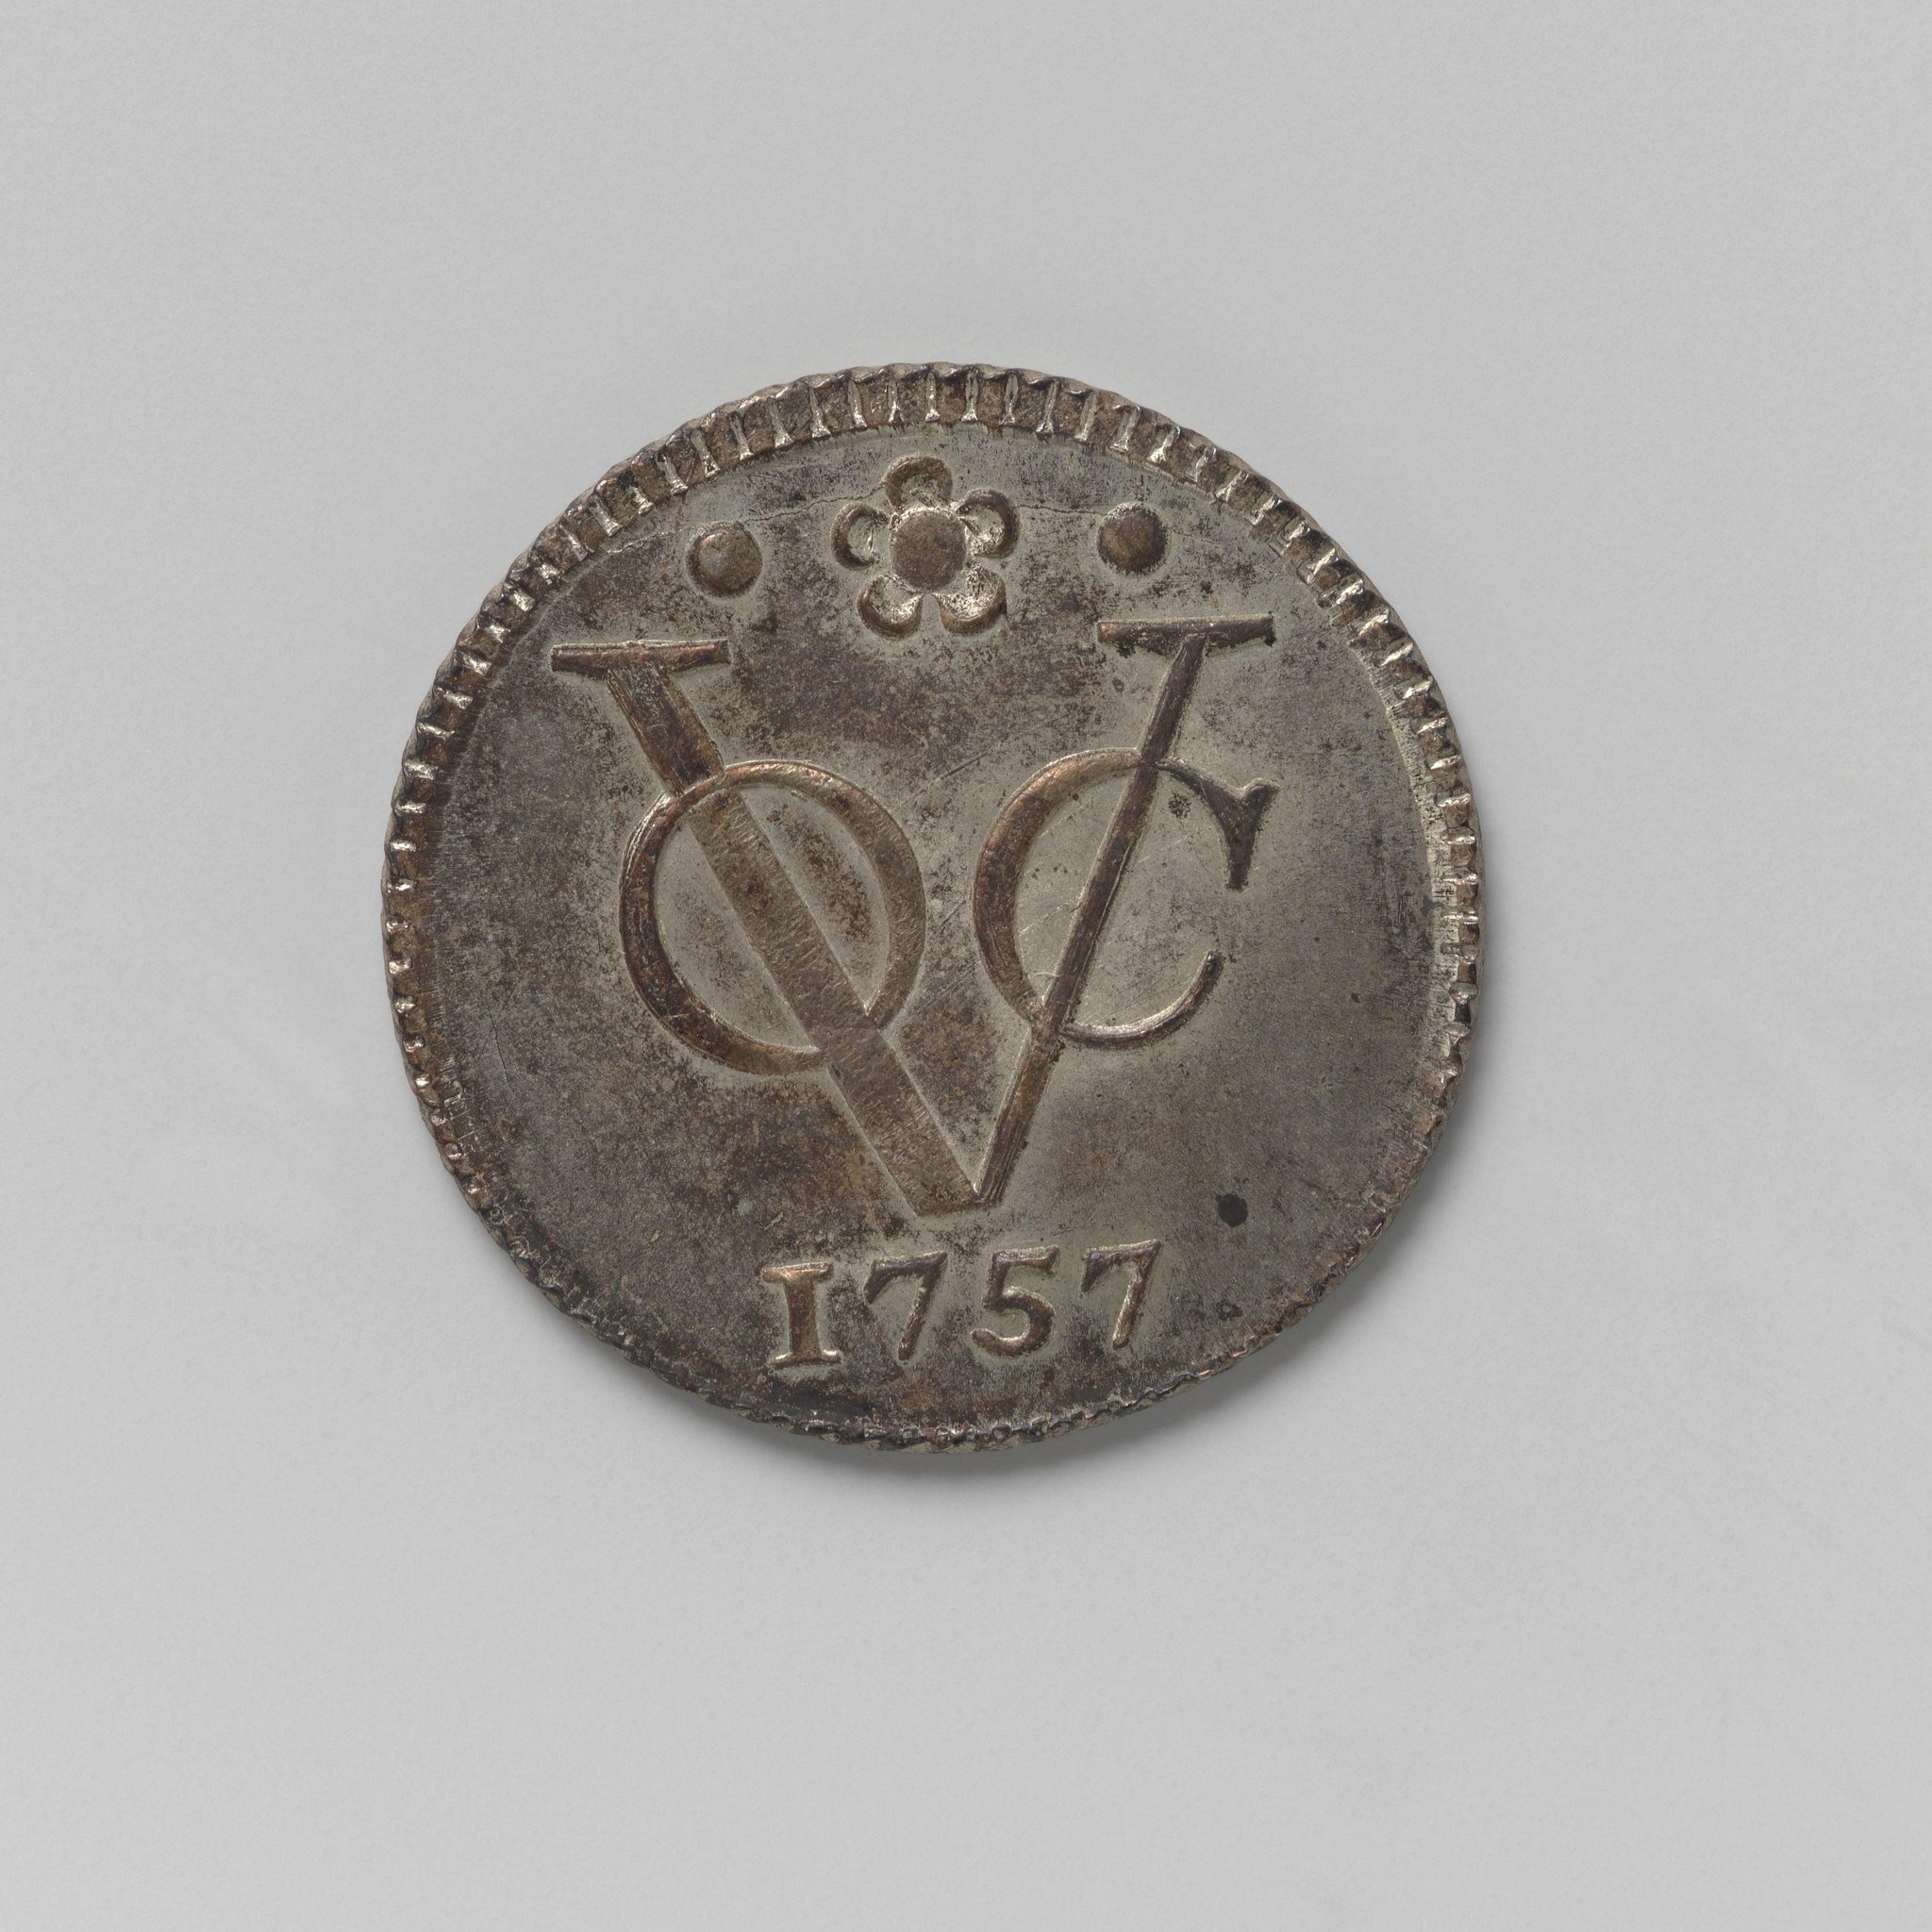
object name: coin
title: Zilveren afslag van een ½ duit van de VOC uit Holland, 1757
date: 1757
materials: silver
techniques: striking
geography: dordrecht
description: Zilveren munt. Voorzijde: gekroond wapenschild van Holland. Keerzijde: monogram van de VOC, waarboven muntteken en waaronder jaartal. Kabelrand.